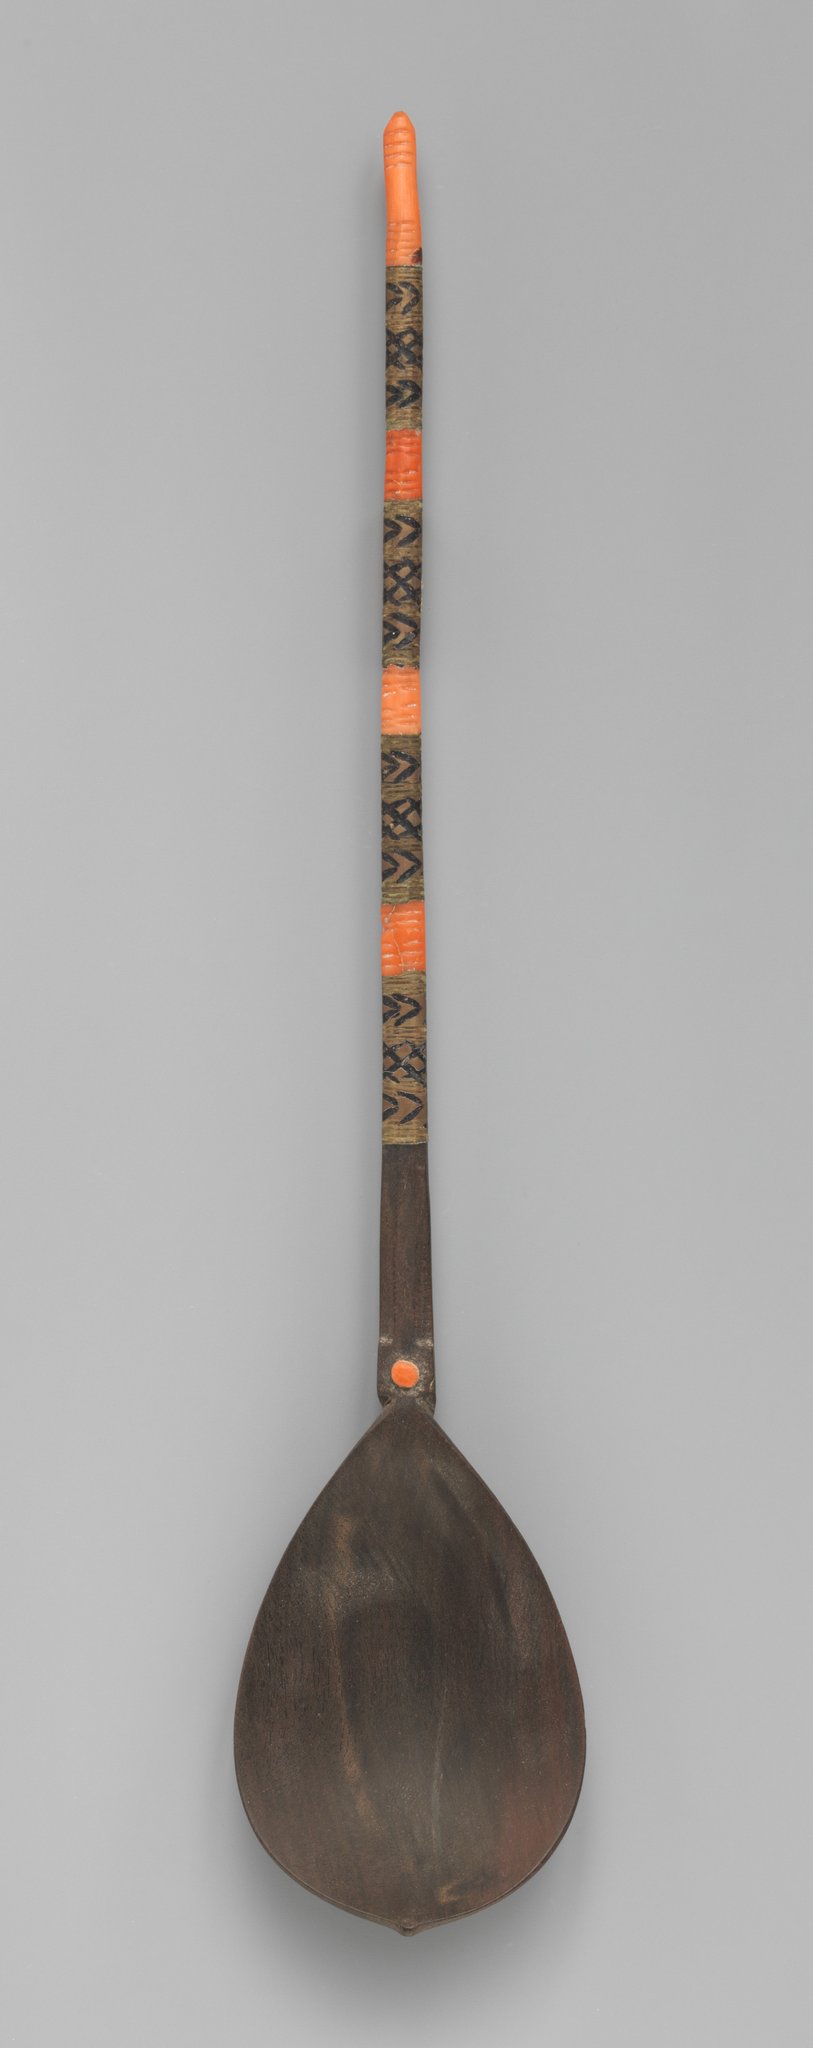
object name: spoon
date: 1701-1800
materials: brass, coral, wood